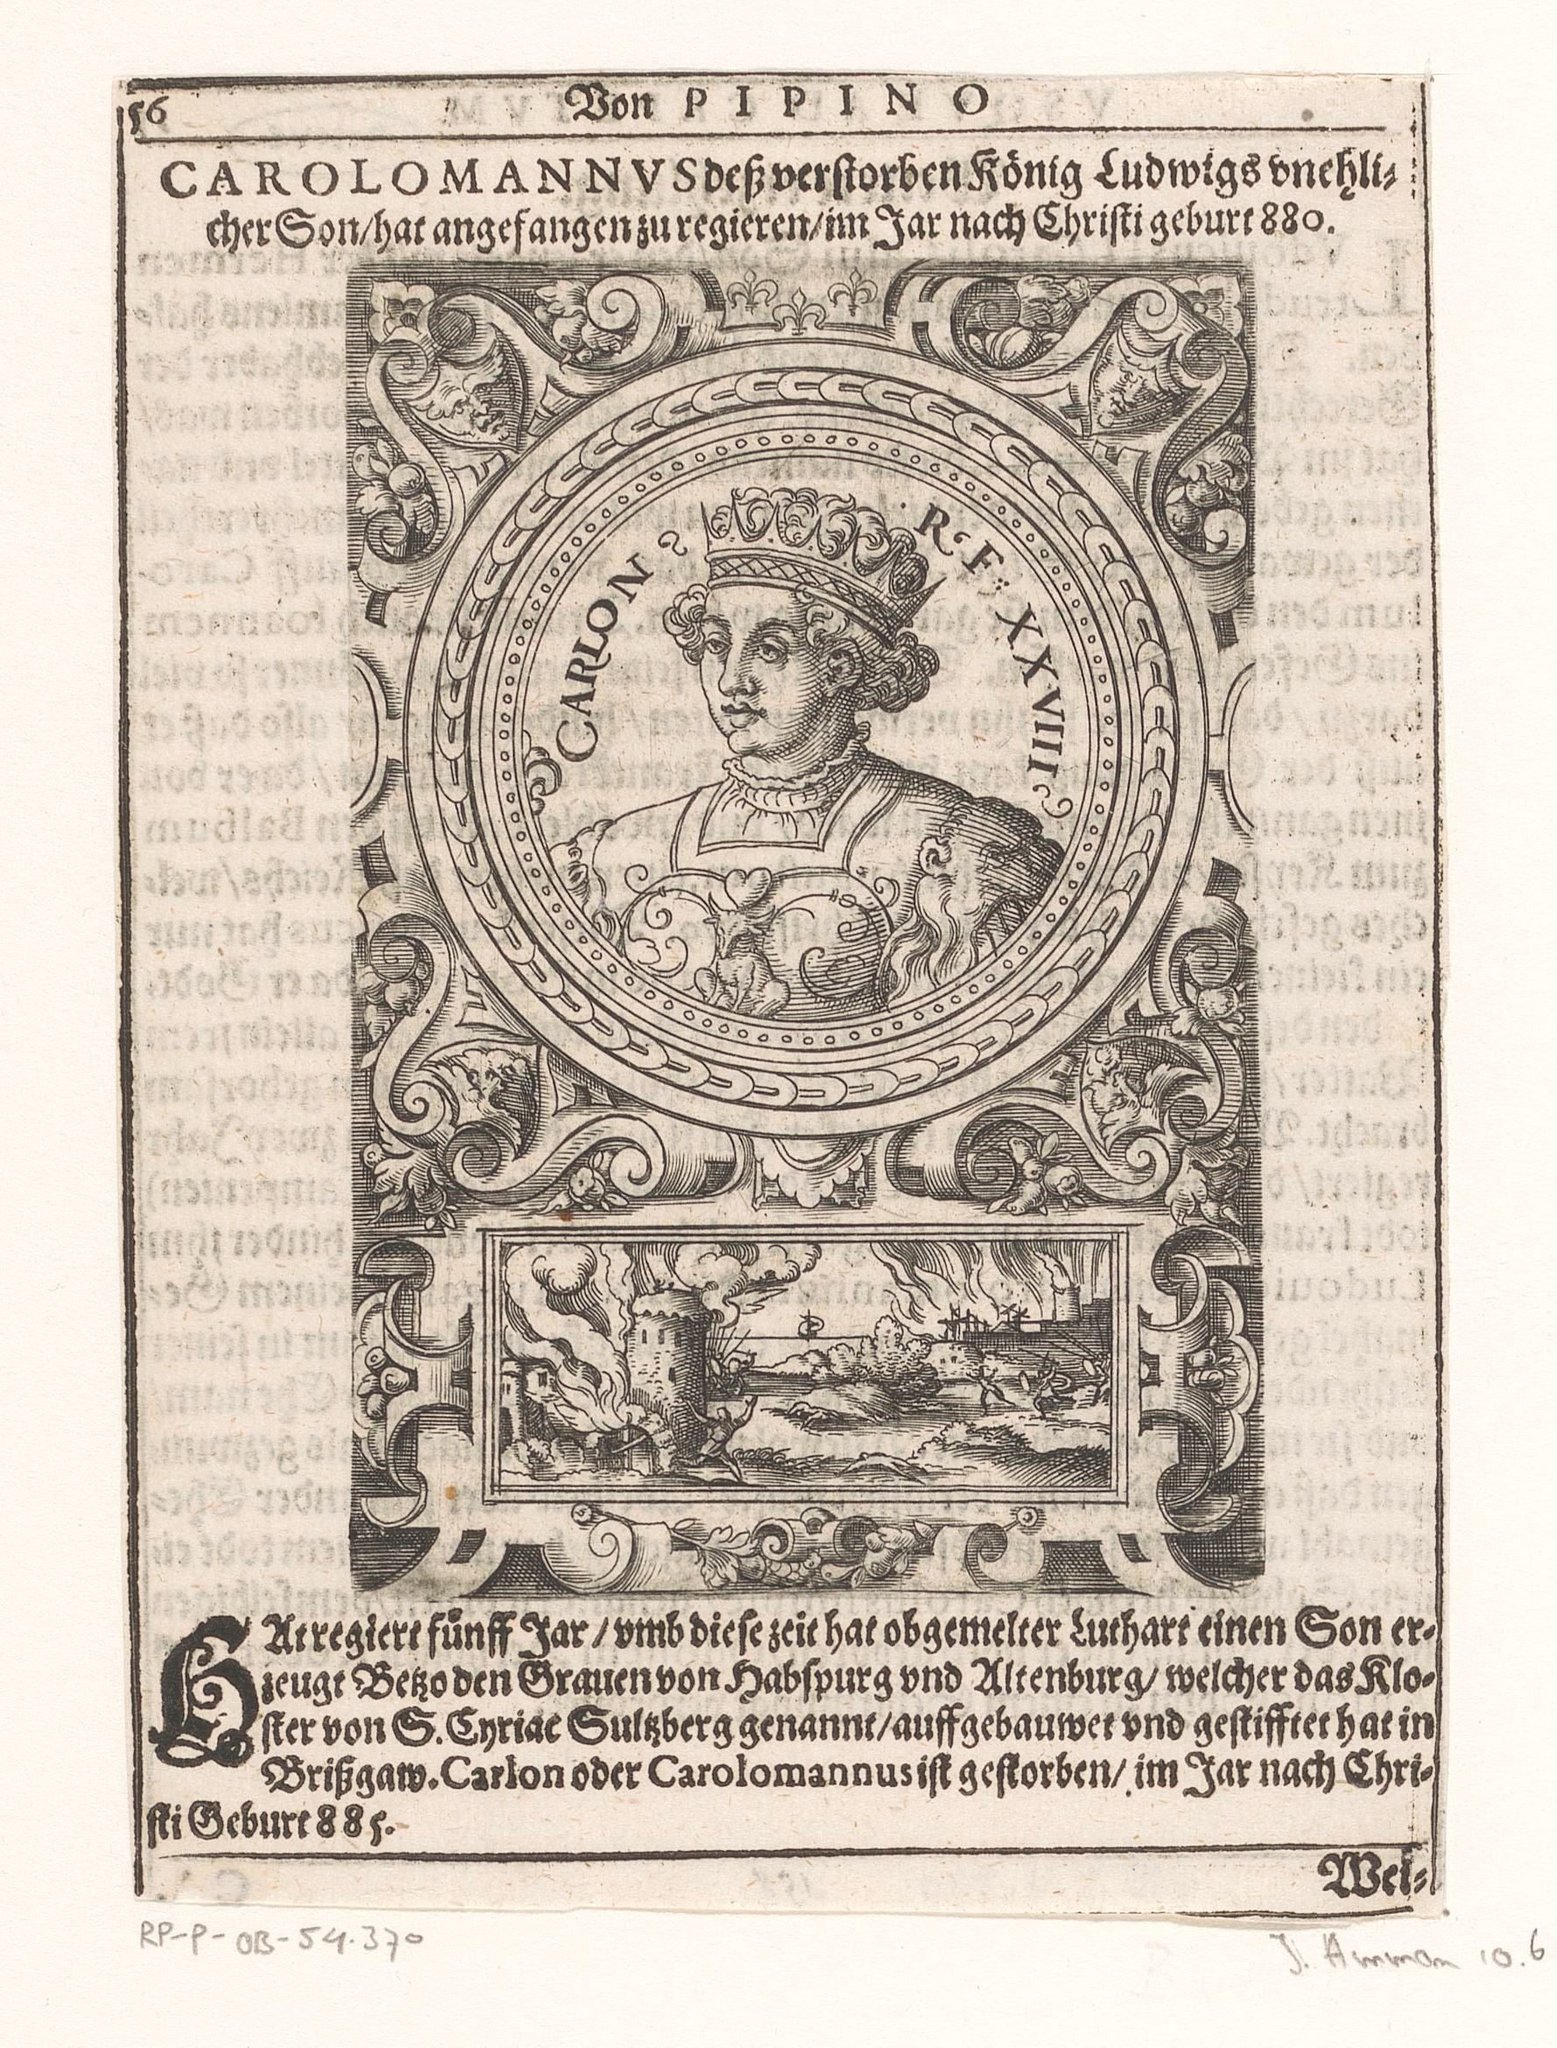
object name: print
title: Portret van Karloman II, koning van West-Francië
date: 1598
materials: paper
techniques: engraving, etching, intaglio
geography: nuremberg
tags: scrollwork, strapwork ~ ornament, historical persons, ruler, sovereign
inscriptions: number: ‘158’, collector's mark: Lugt 2228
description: Prent afkomstig uit de publicatie: Michael Eizinger. Könige in Frankreich. Keulen: Johann Bussemacher, 1598, p. 56. De publicatie bevat prenten van Jost Amman en Virgil Solis.